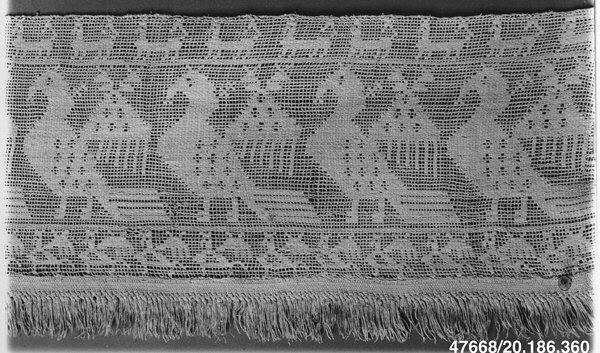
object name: border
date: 1501-1600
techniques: embroidery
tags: birds